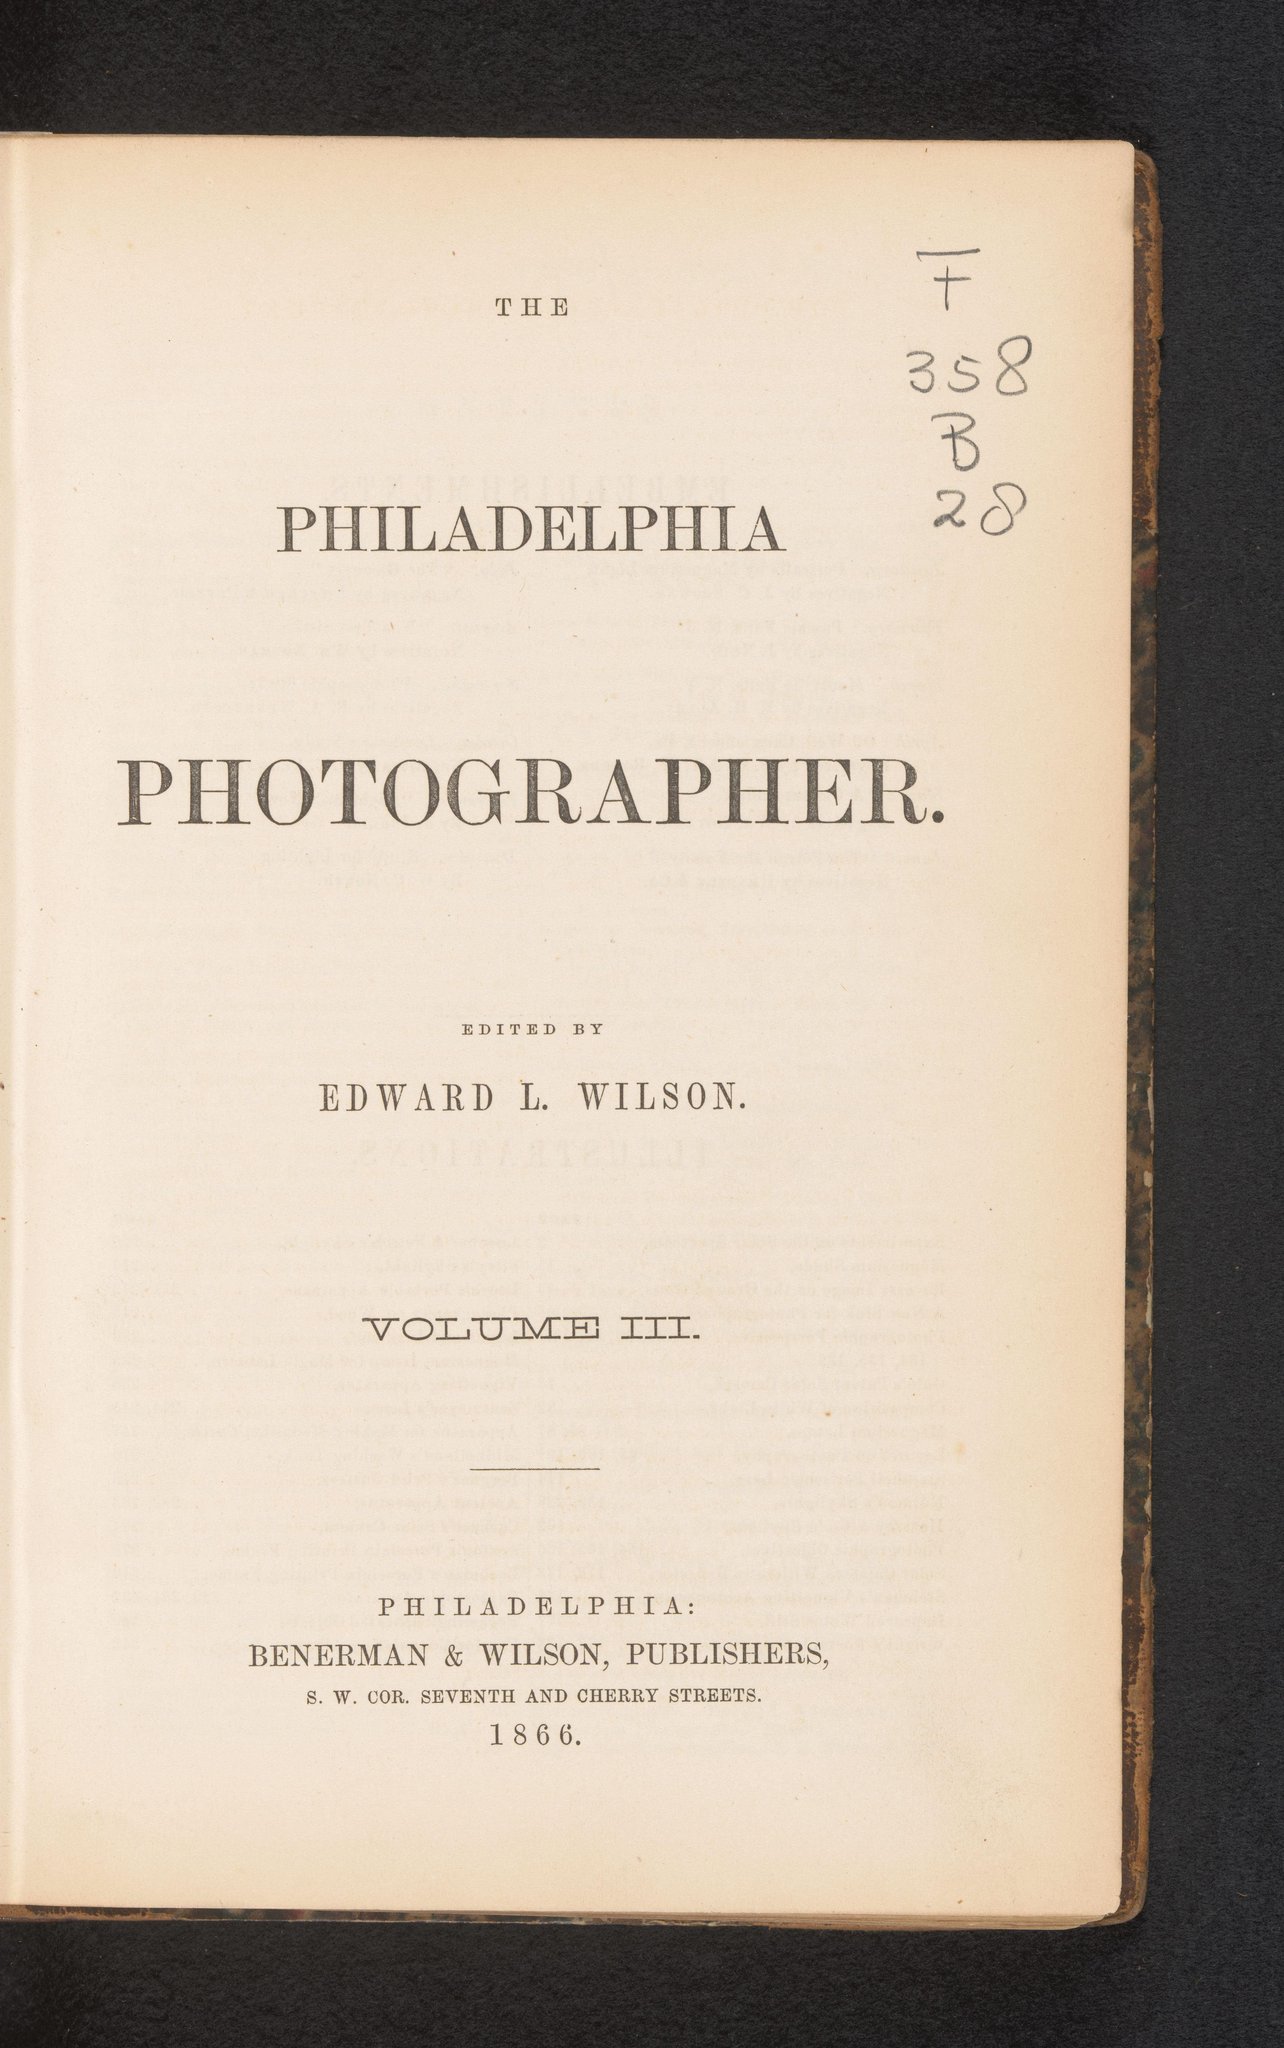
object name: book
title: The Philadelphia Photographer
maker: edward livingston wilson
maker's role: publisher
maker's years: 1838-1903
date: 1866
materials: leather, linen, paper, photographic support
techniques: albumen print, printing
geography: philadelphia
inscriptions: annotation: ‘DEC/1999’, annotation: ‘F’, monogram: ‘AF.’